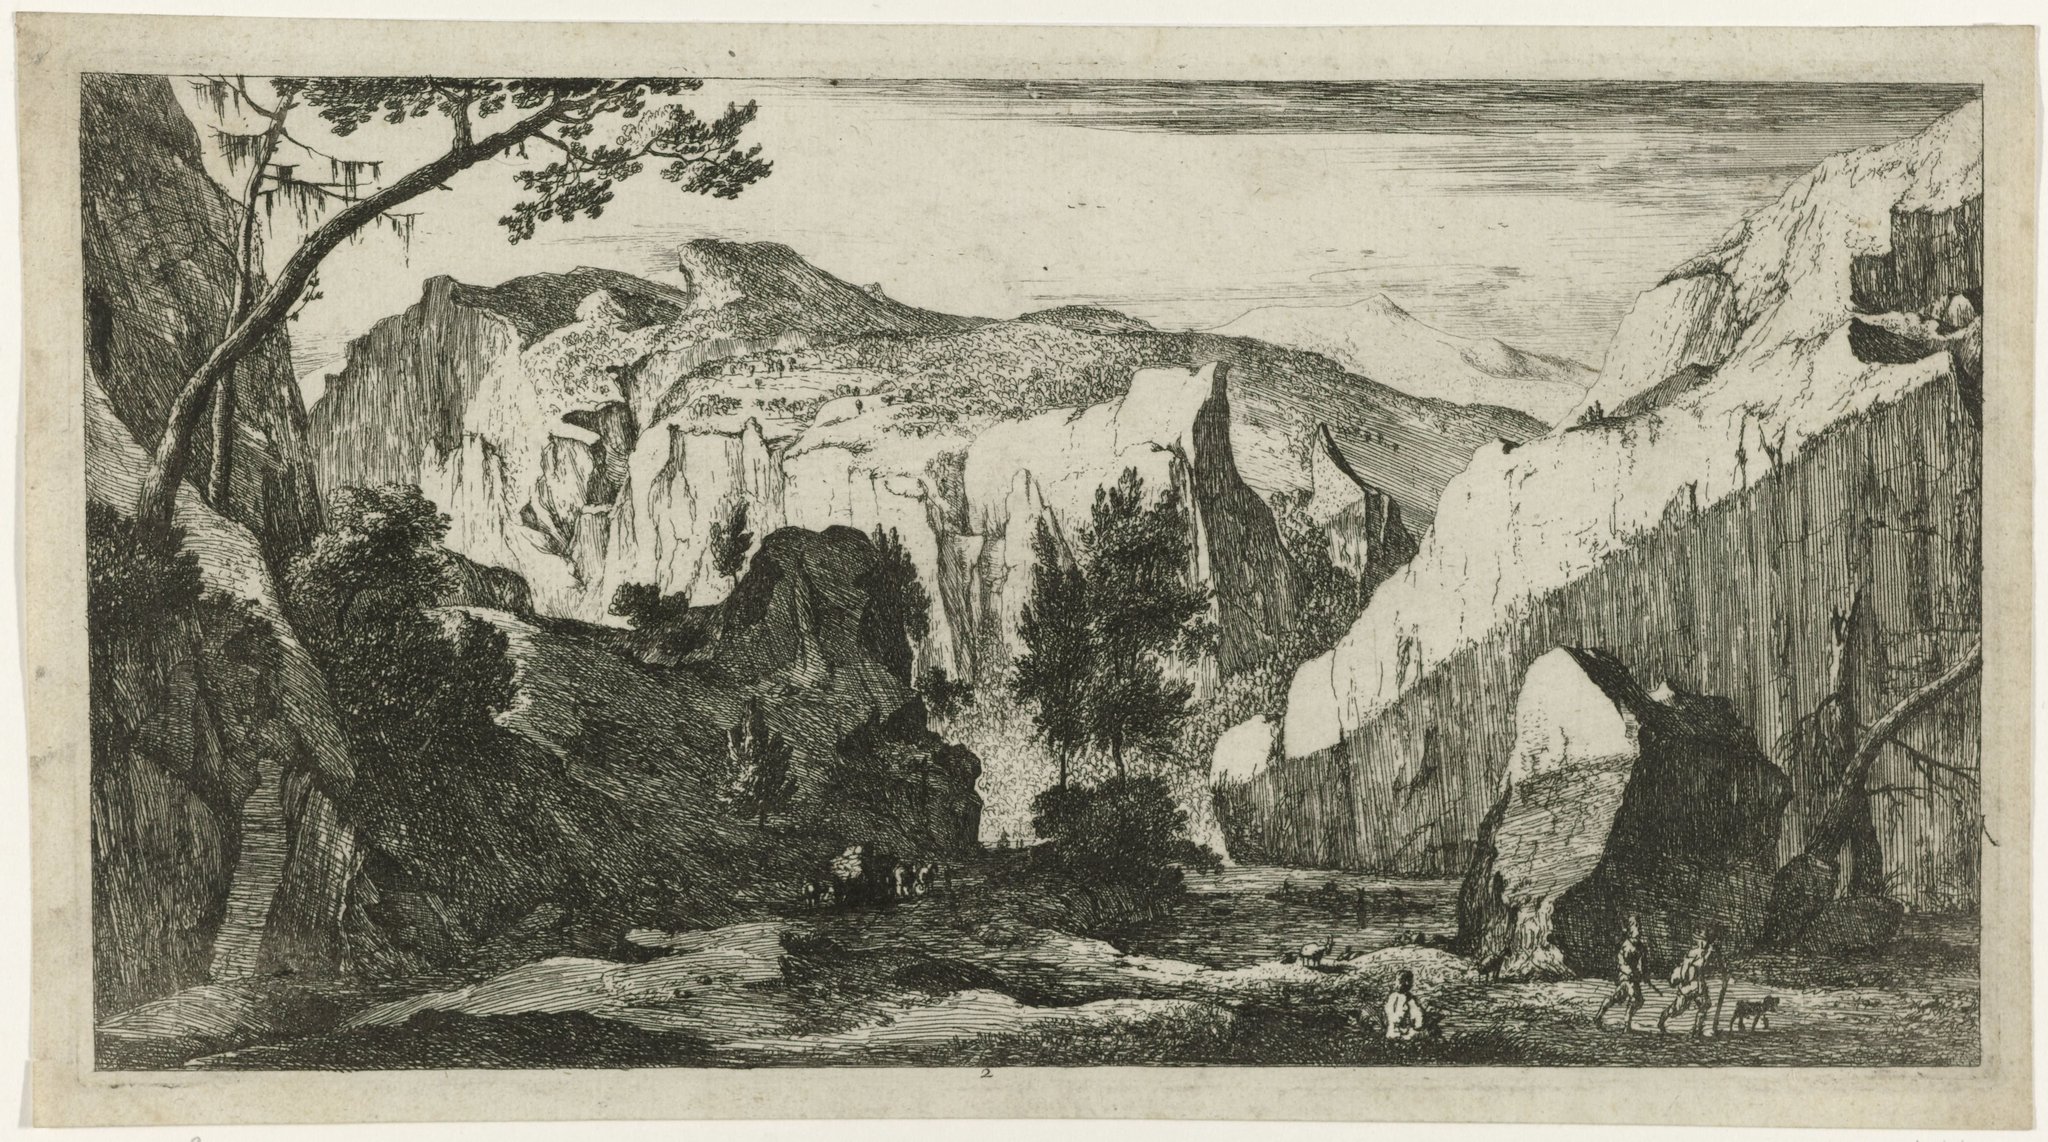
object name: print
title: Berglandschap met rotsen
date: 1647-1692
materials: paper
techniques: etching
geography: amsterdam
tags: river, goat, 'en route', traveller under way, rocks, dog, mountains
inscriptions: stamp: ‘Erichson Kubenhavn’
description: Gezicht op een berglandschap met rotsen in Tirol. Op de voorgrond twee herders met een hond. Aan het water een geit en op de achtergrond een door paarden getrokken volgeladen kar. Prent uit een serie van acht prenten met Tiroolse landschappen.